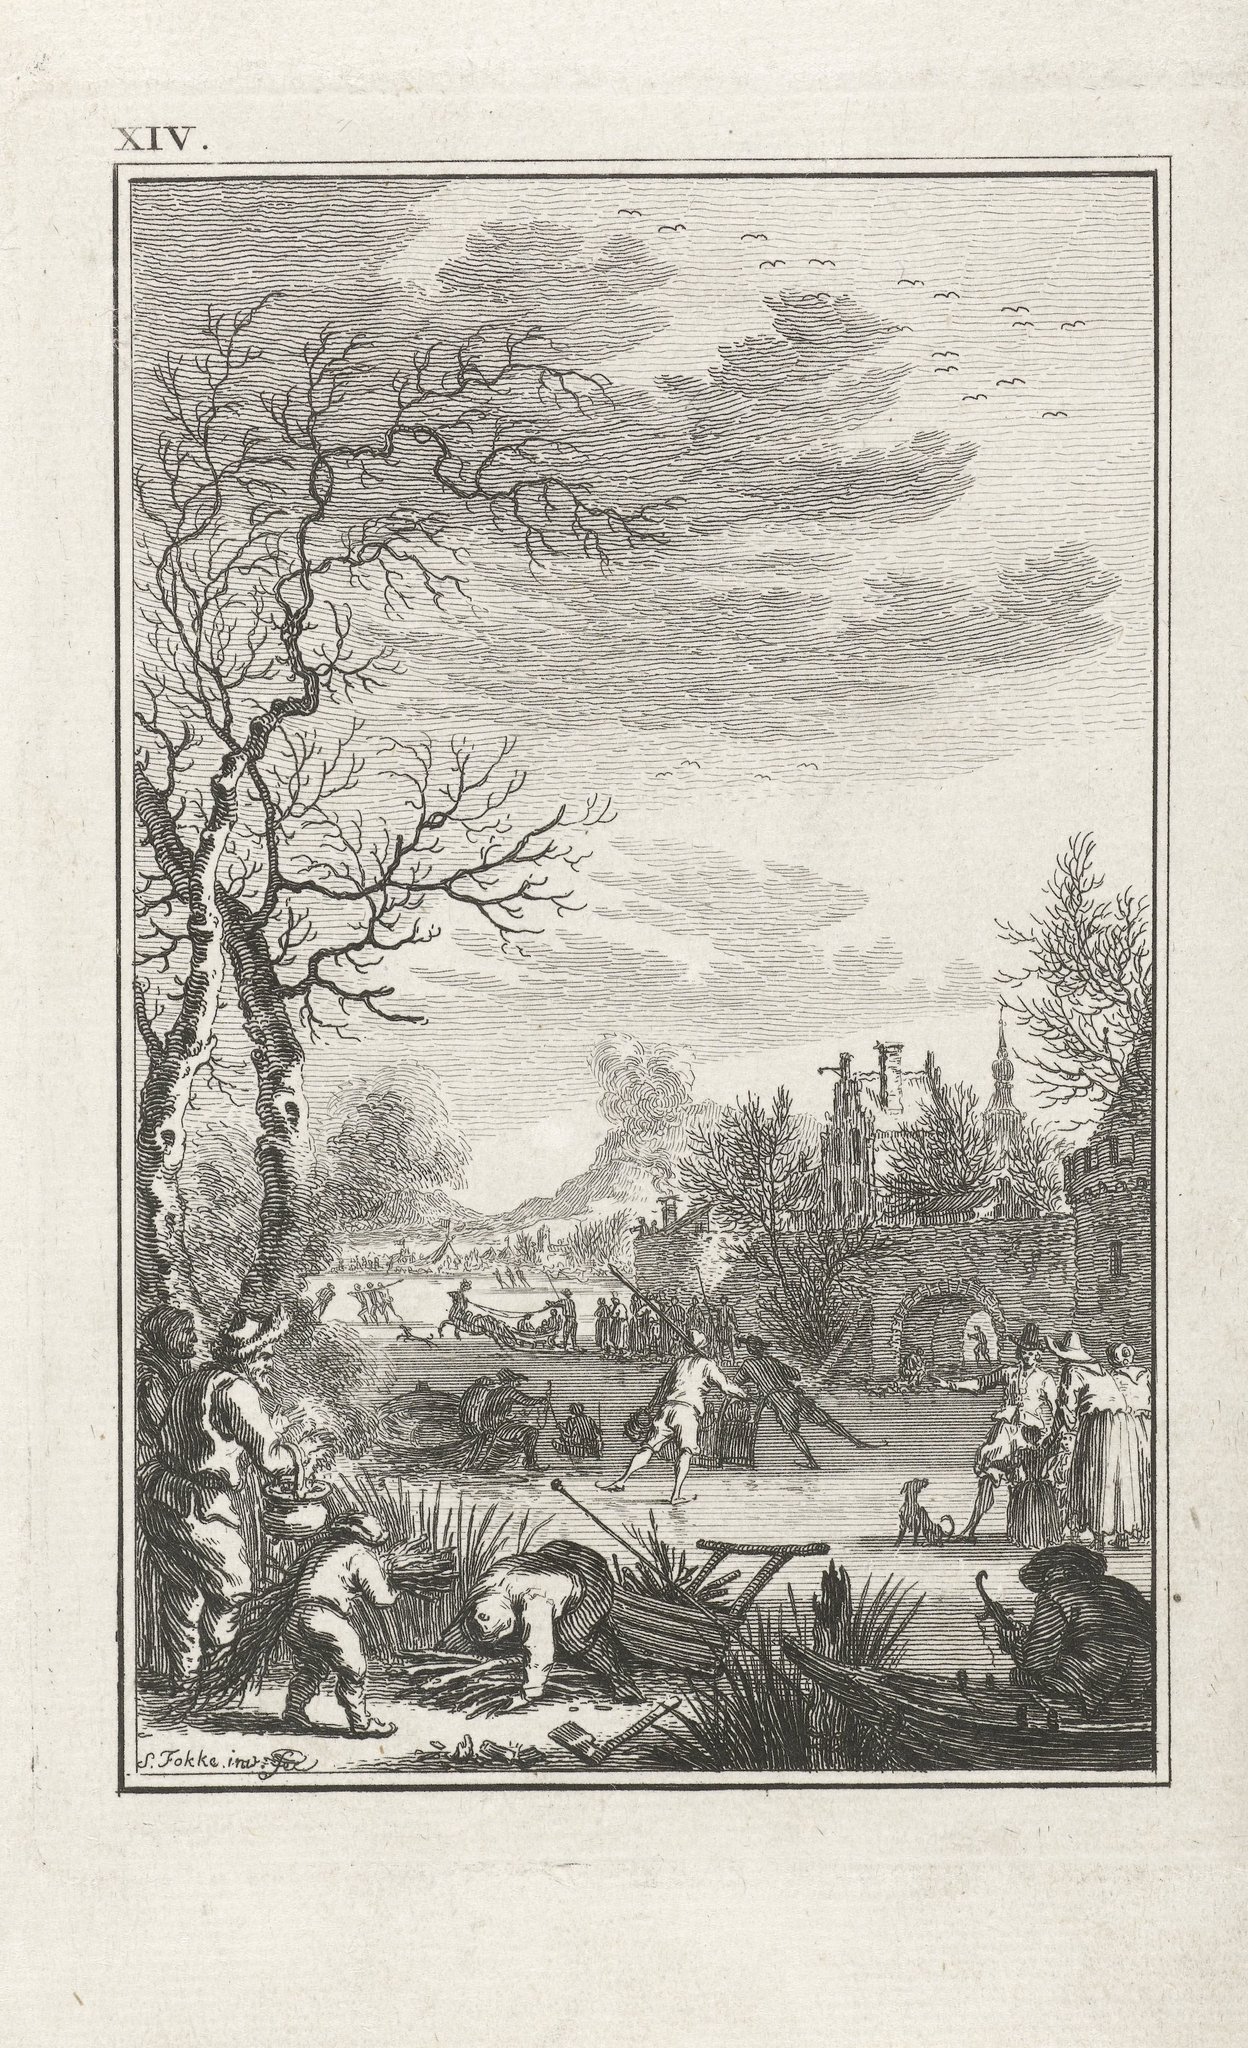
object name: book illustration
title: IJsgezicht nabij een stad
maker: simon fokke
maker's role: draughtsman, print maker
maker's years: 1712-1784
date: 1722-1784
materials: paper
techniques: etching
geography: amsterdam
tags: woodgathering, woodgatherer, winter landscape; landscape symbolizing winter (the four seasons of the year), skates (winter sports)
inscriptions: collector's mark: Lugt 2228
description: IJsvermaak en vissers op bevroren water nabij een stad. Op de voorgrond sprokkelen figuren hout. Prent linksboven gemerkt: XIV.